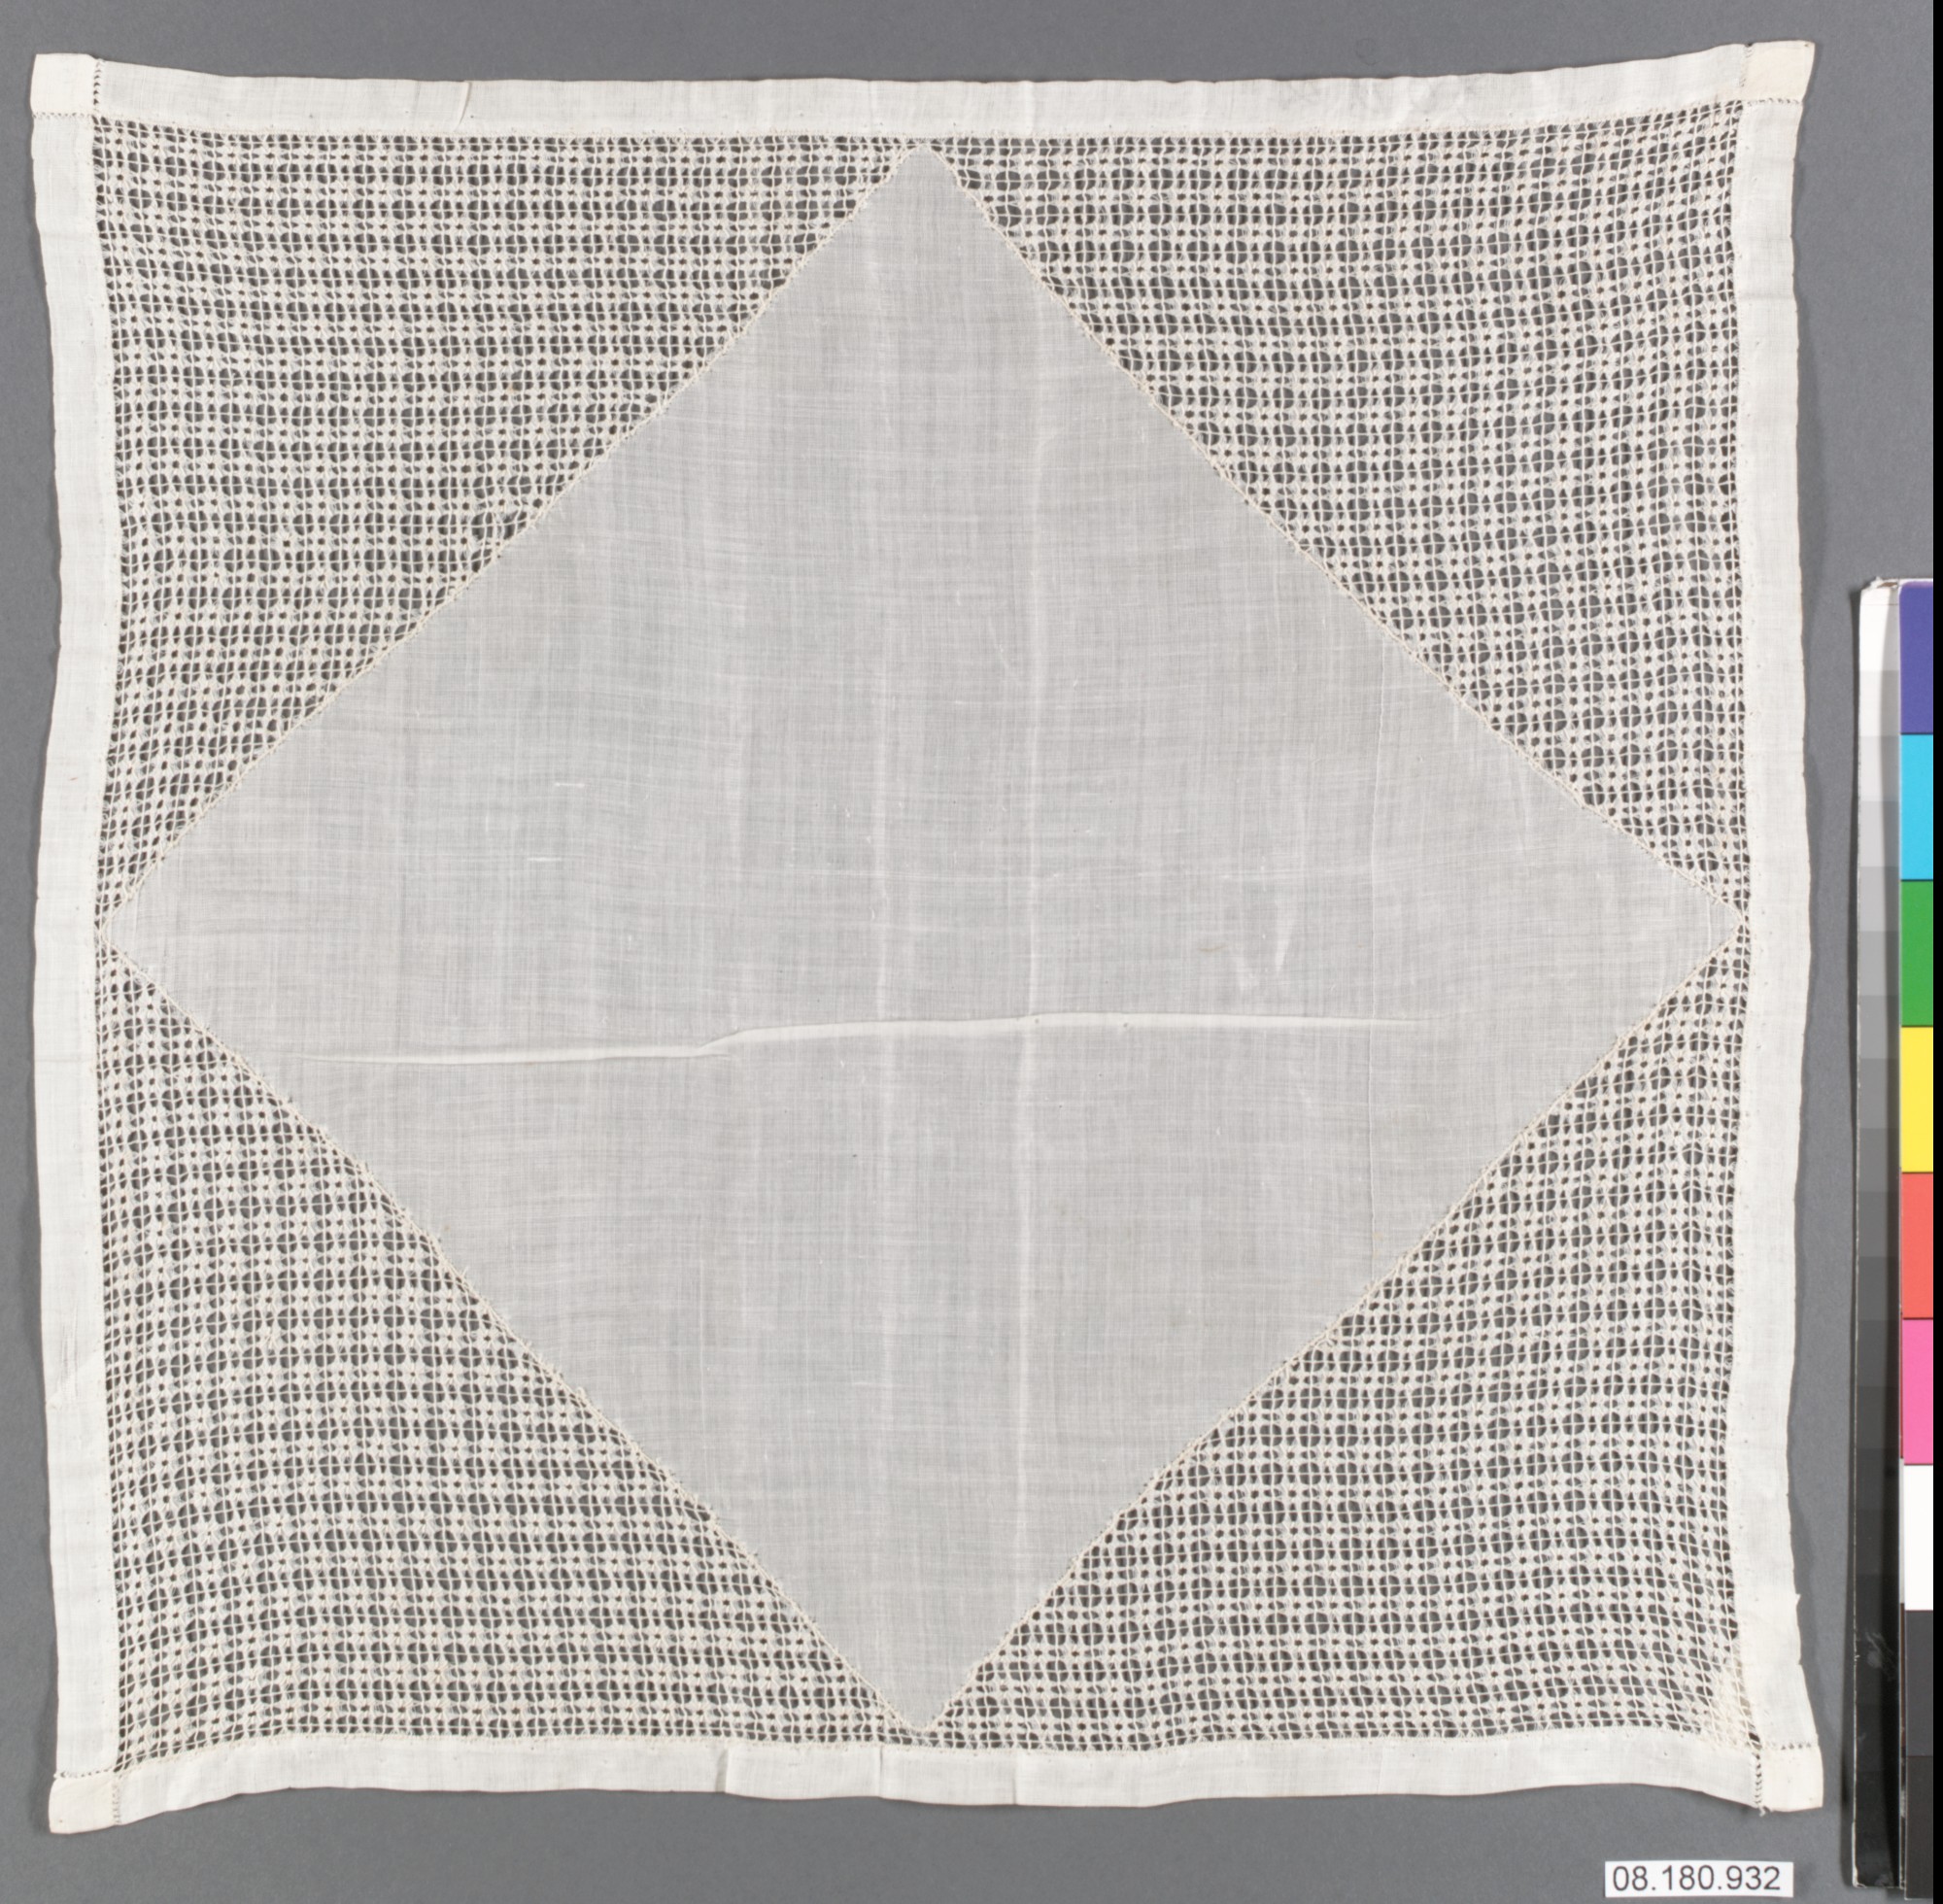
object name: handkerchief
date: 1801-1900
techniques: embroidery